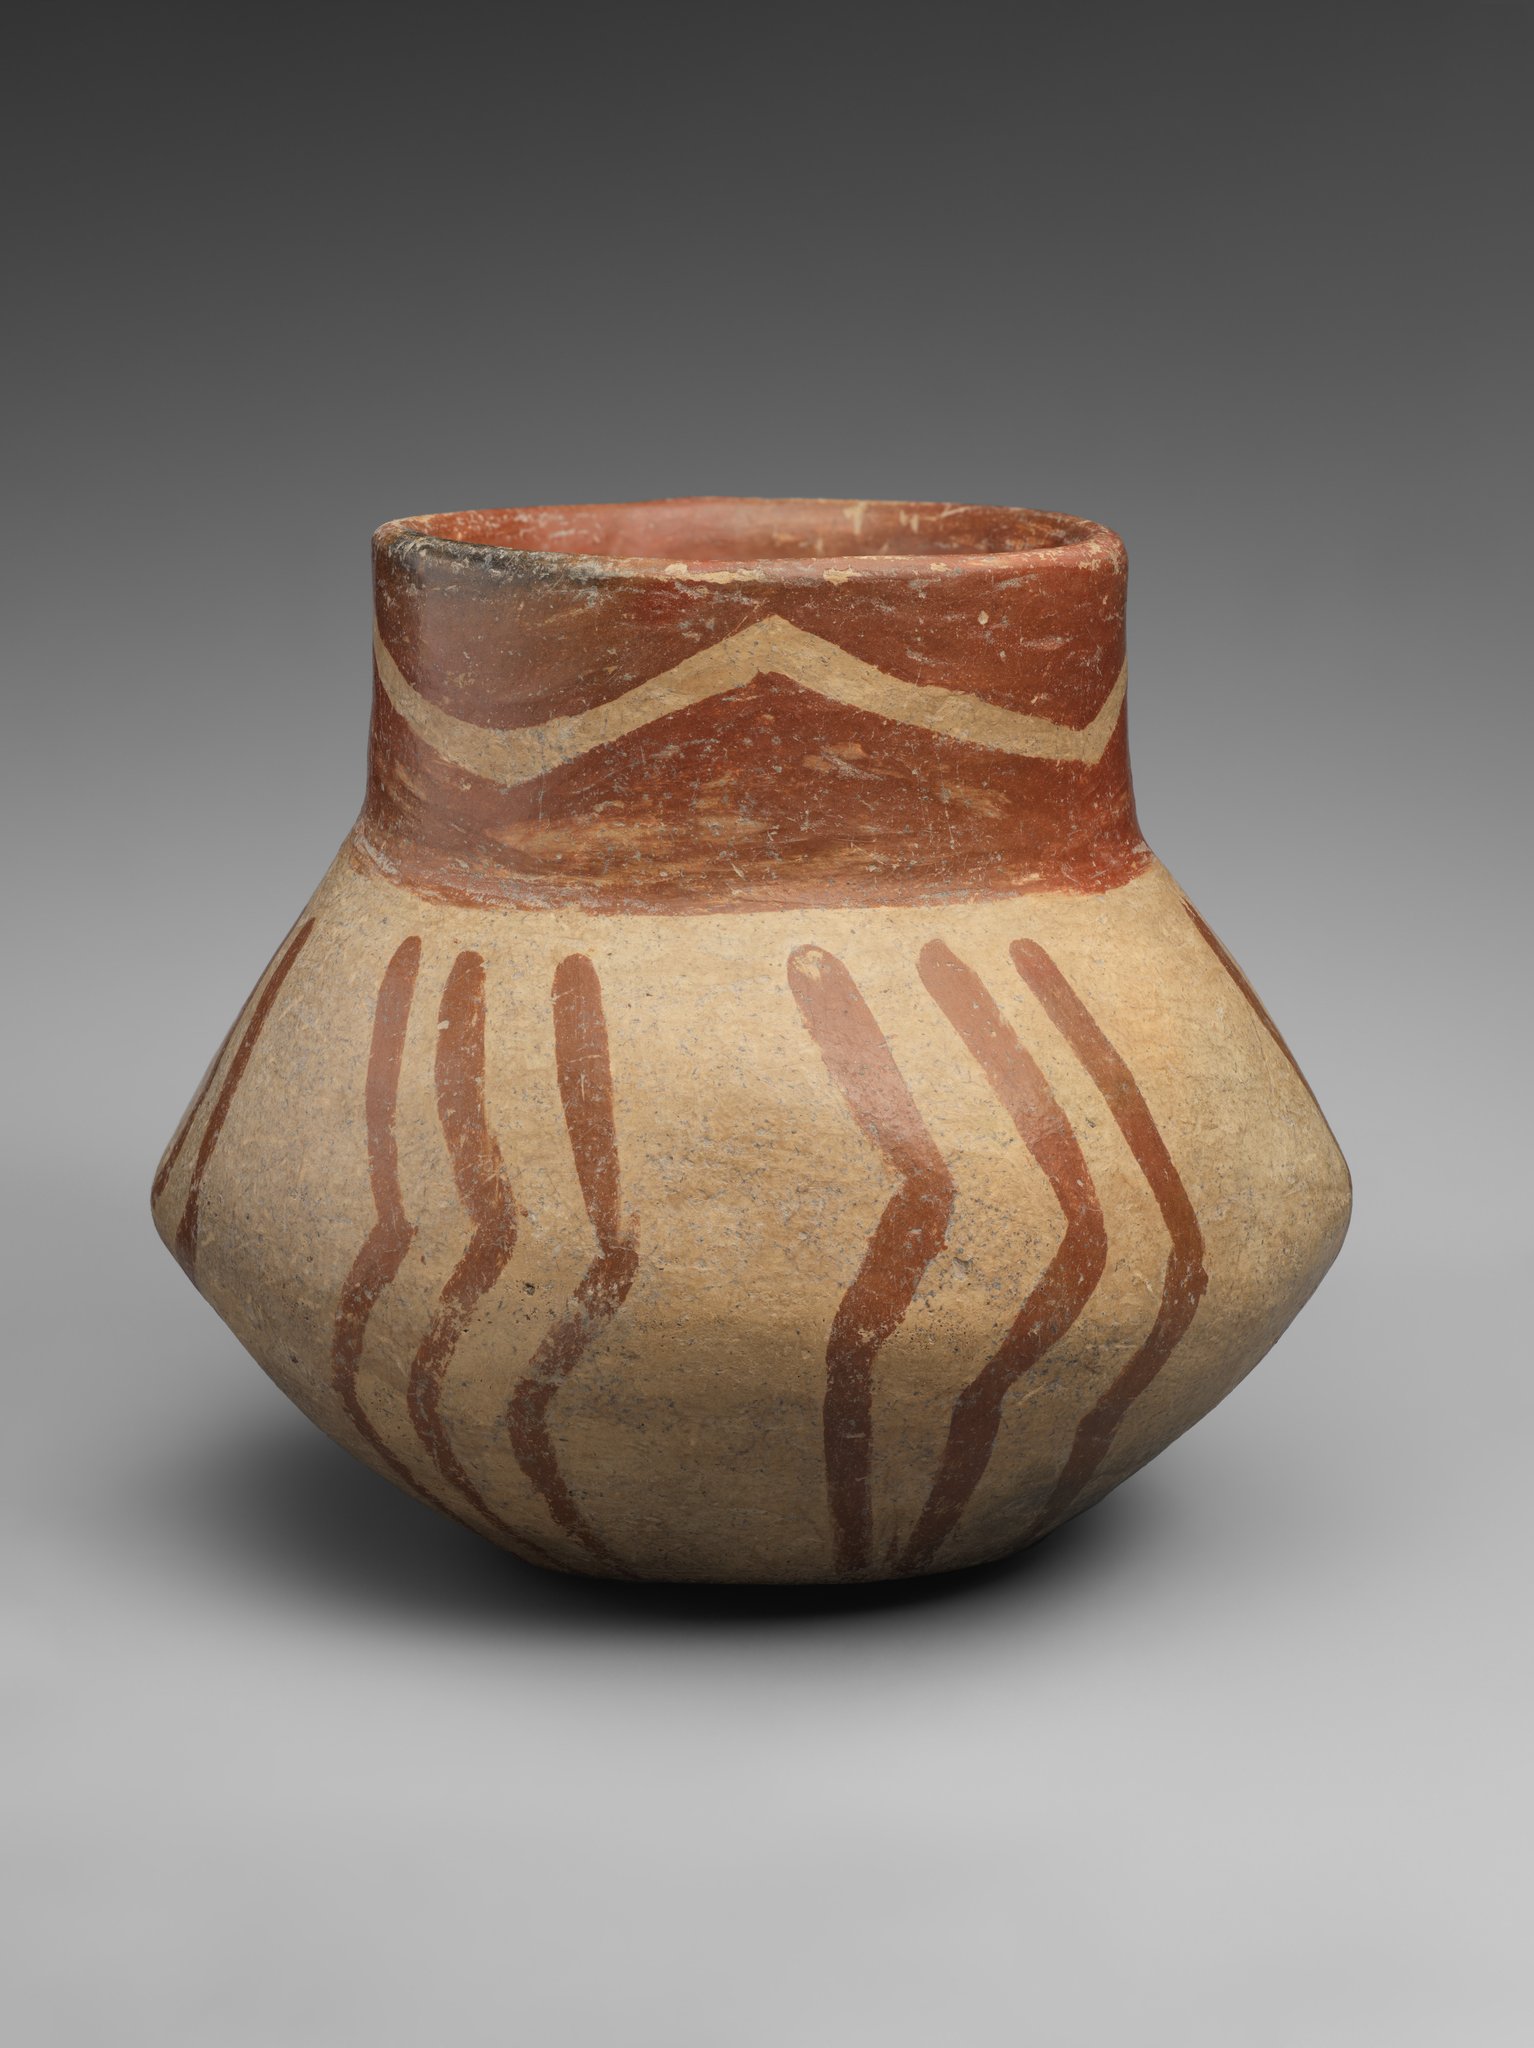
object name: vessel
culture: hacilar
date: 5600-5400 BCE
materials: ceramic, paint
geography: southwestern anatolia